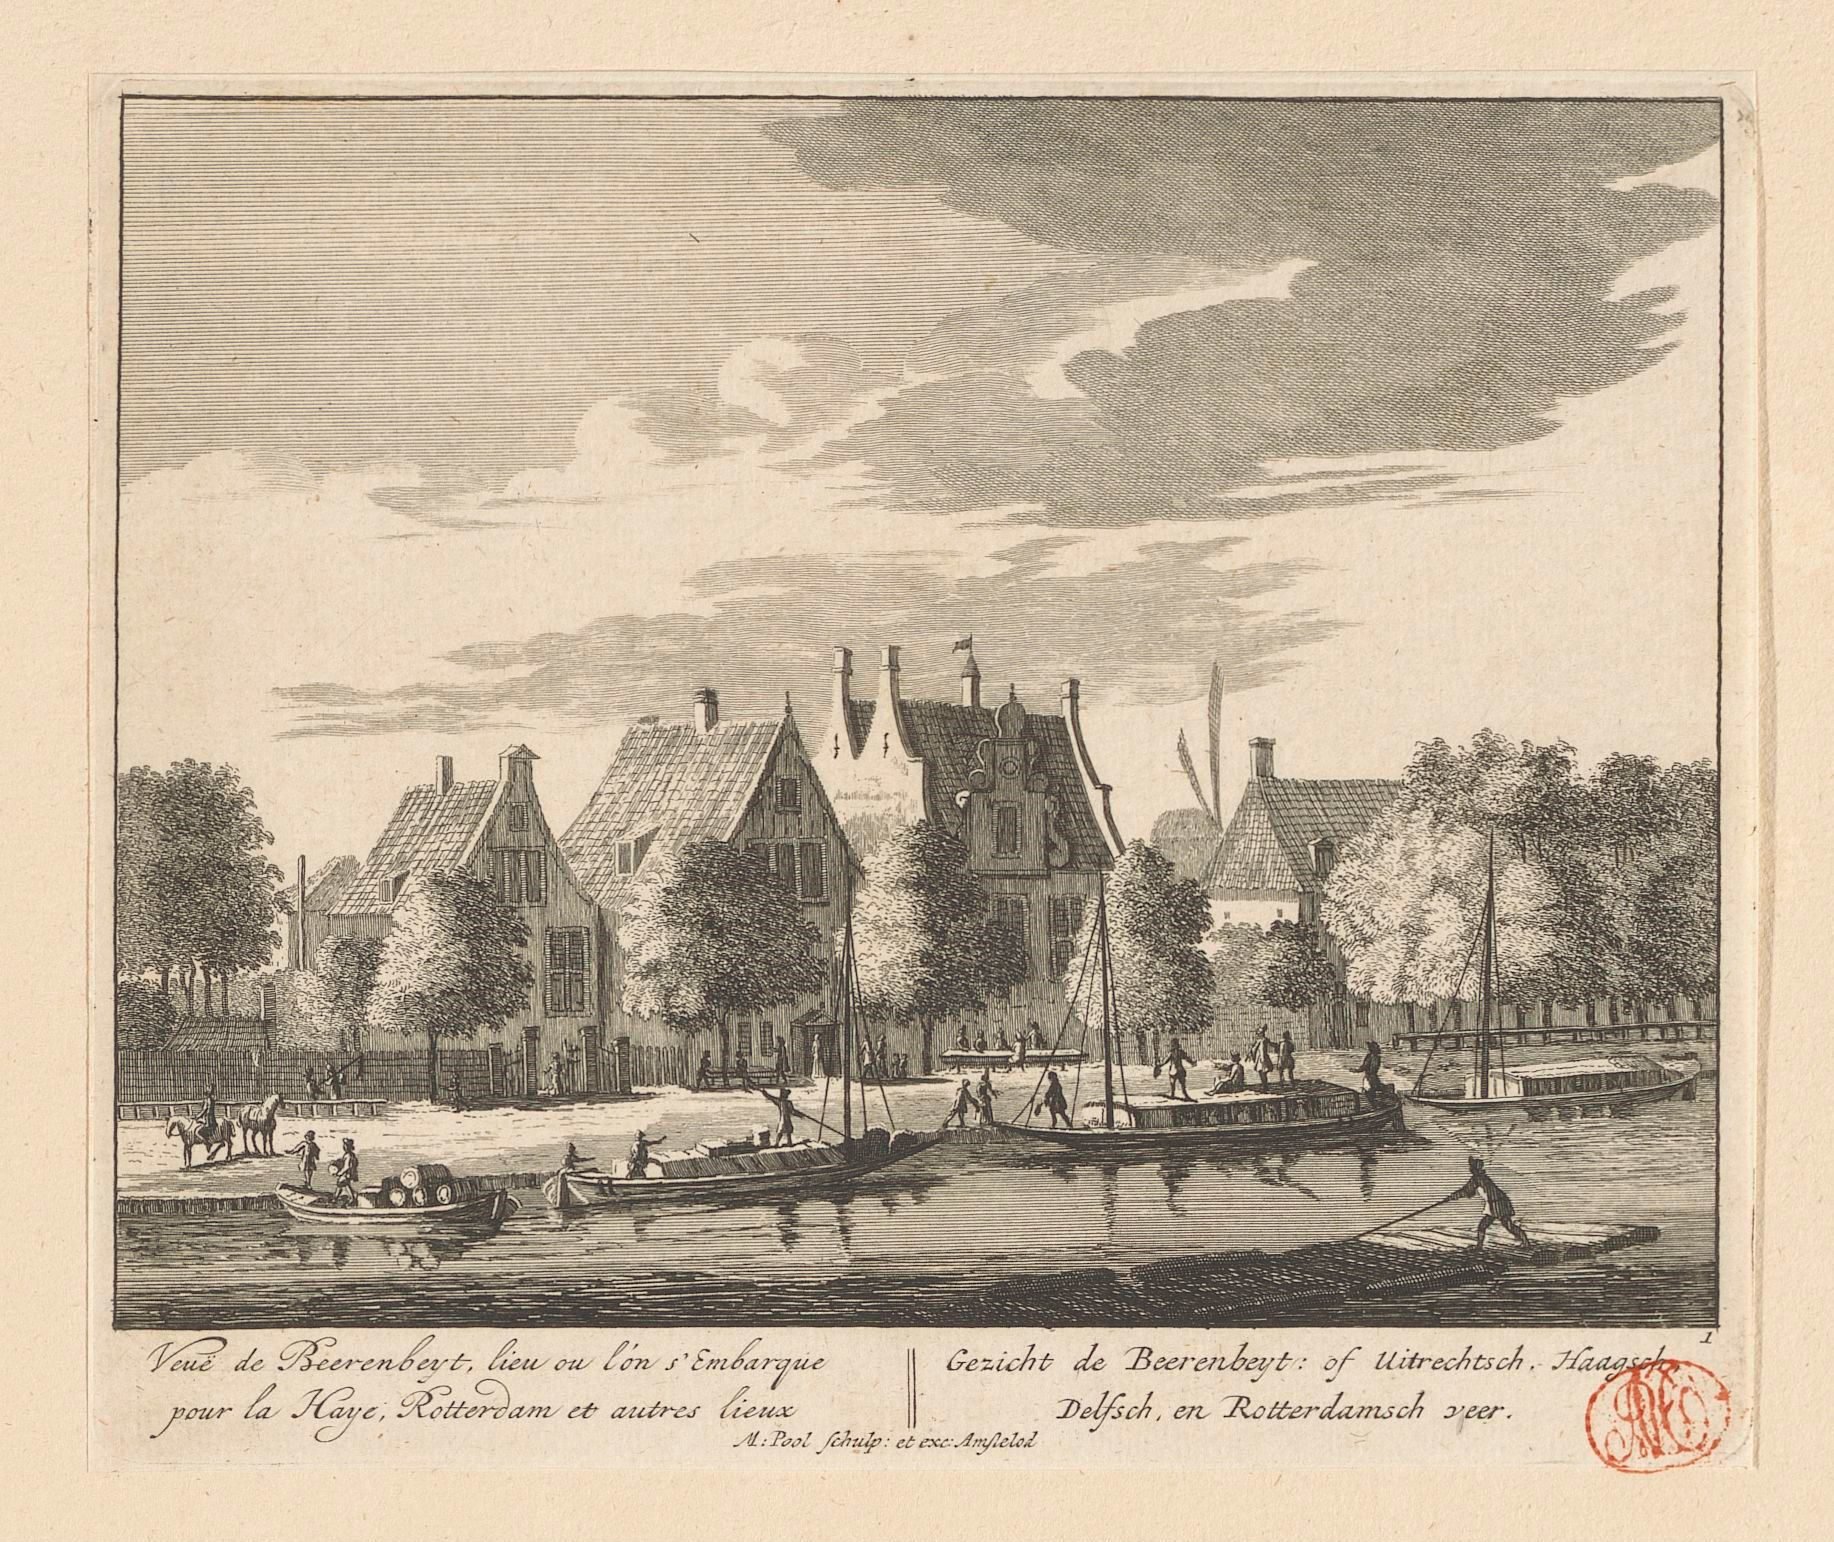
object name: print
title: Gezicht op de Amstel bij herberg de Beerebijt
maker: matthijs pool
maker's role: print maker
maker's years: 1676-1740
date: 1708-1740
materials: paper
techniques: engraving, etching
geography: amsterdam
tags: river, hotel, hostelry, inn, boat propelled by man or animal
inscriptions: collector's mark: Lugt 195, collector's mark: Lugt 2233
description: Prent gebruikt in: Pool, Matthijs. Verscheyde gesigten van de vermaarde rievier de buyten Amstel van de stadt Amsterdam, tot het dorp Ouwerkerk (…) / Plusieurs veuës et perspectives de la fameuse riviére de Buyten-Amstel depuis Amsterdam jusqu'au village d'Ouwerkerk (…). Amsterdam: Matthijs Pool, z.j. [1708-1740].